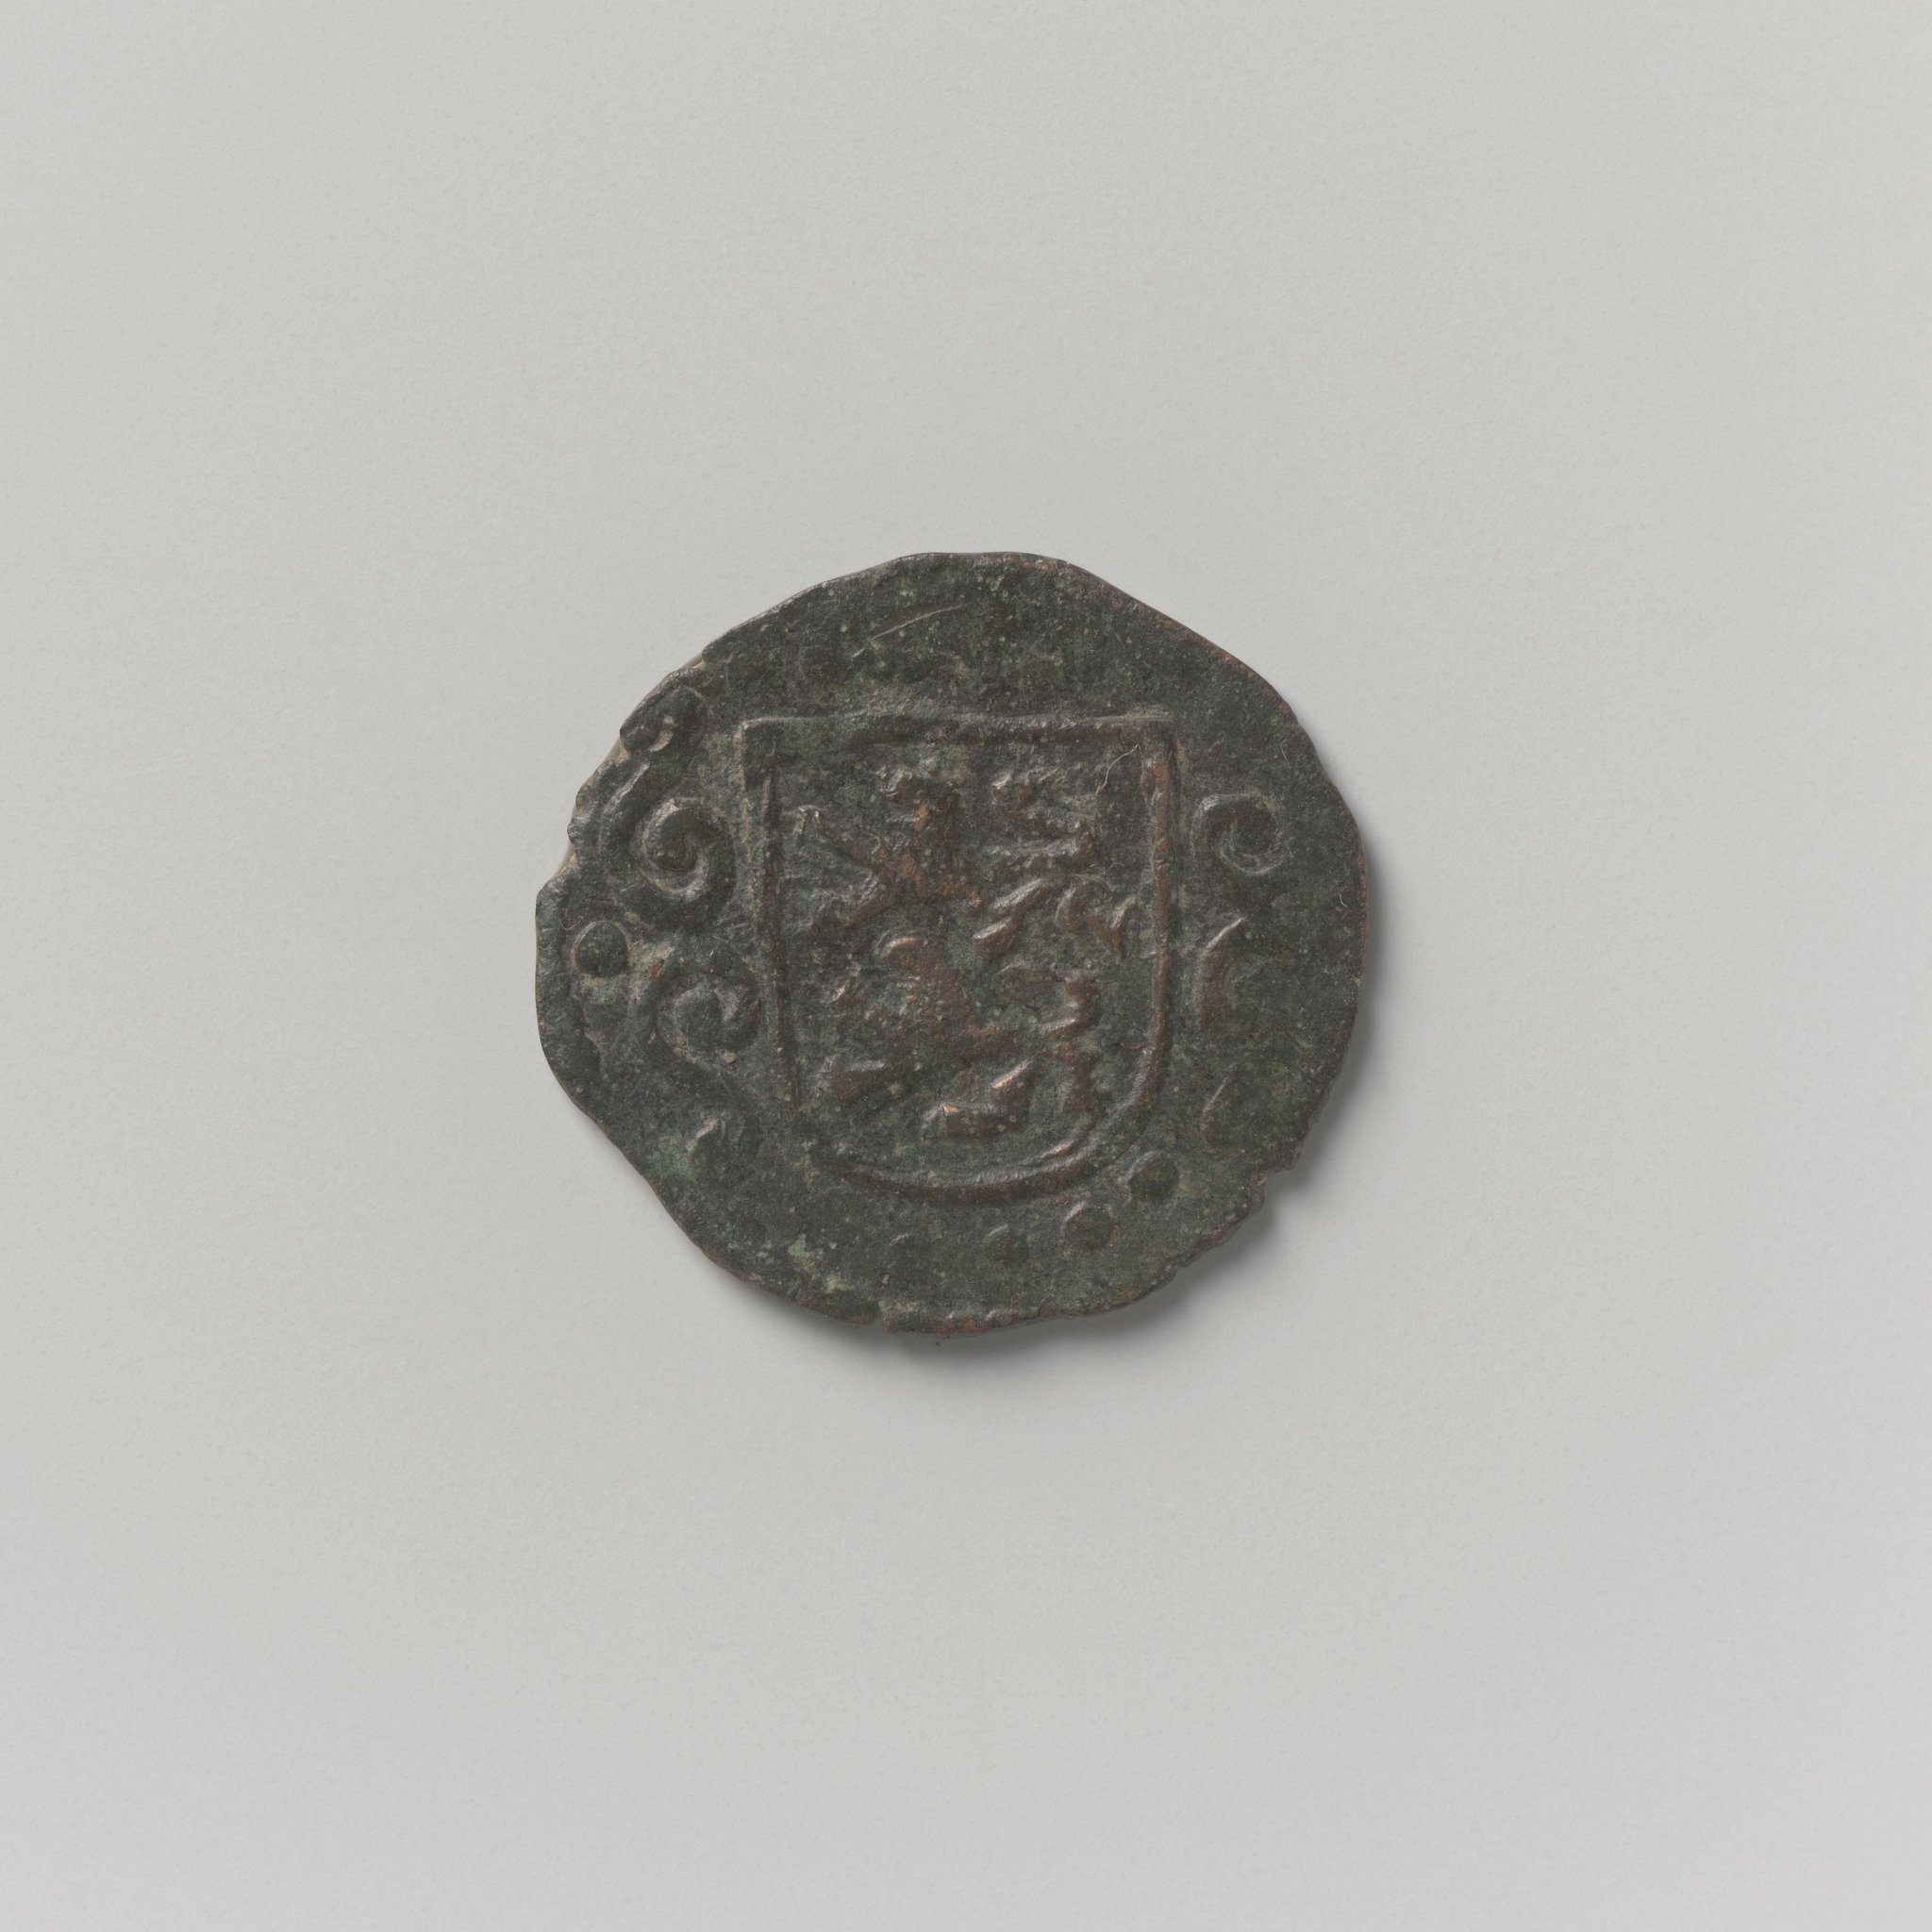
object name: coin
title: Reckheim, Ferdinand van Aspremont-Lynden (1636-1665), duit, 1652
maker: heer van reckheim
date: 1652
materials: copper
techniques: striking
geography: rekem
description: Koperen munt. Voorzijde: versierd wapenschild van Friesland, onder het schild vijf rondjes. Keerzijde: binnen een krans twee-regelig opschrift, waaronder jaartal.